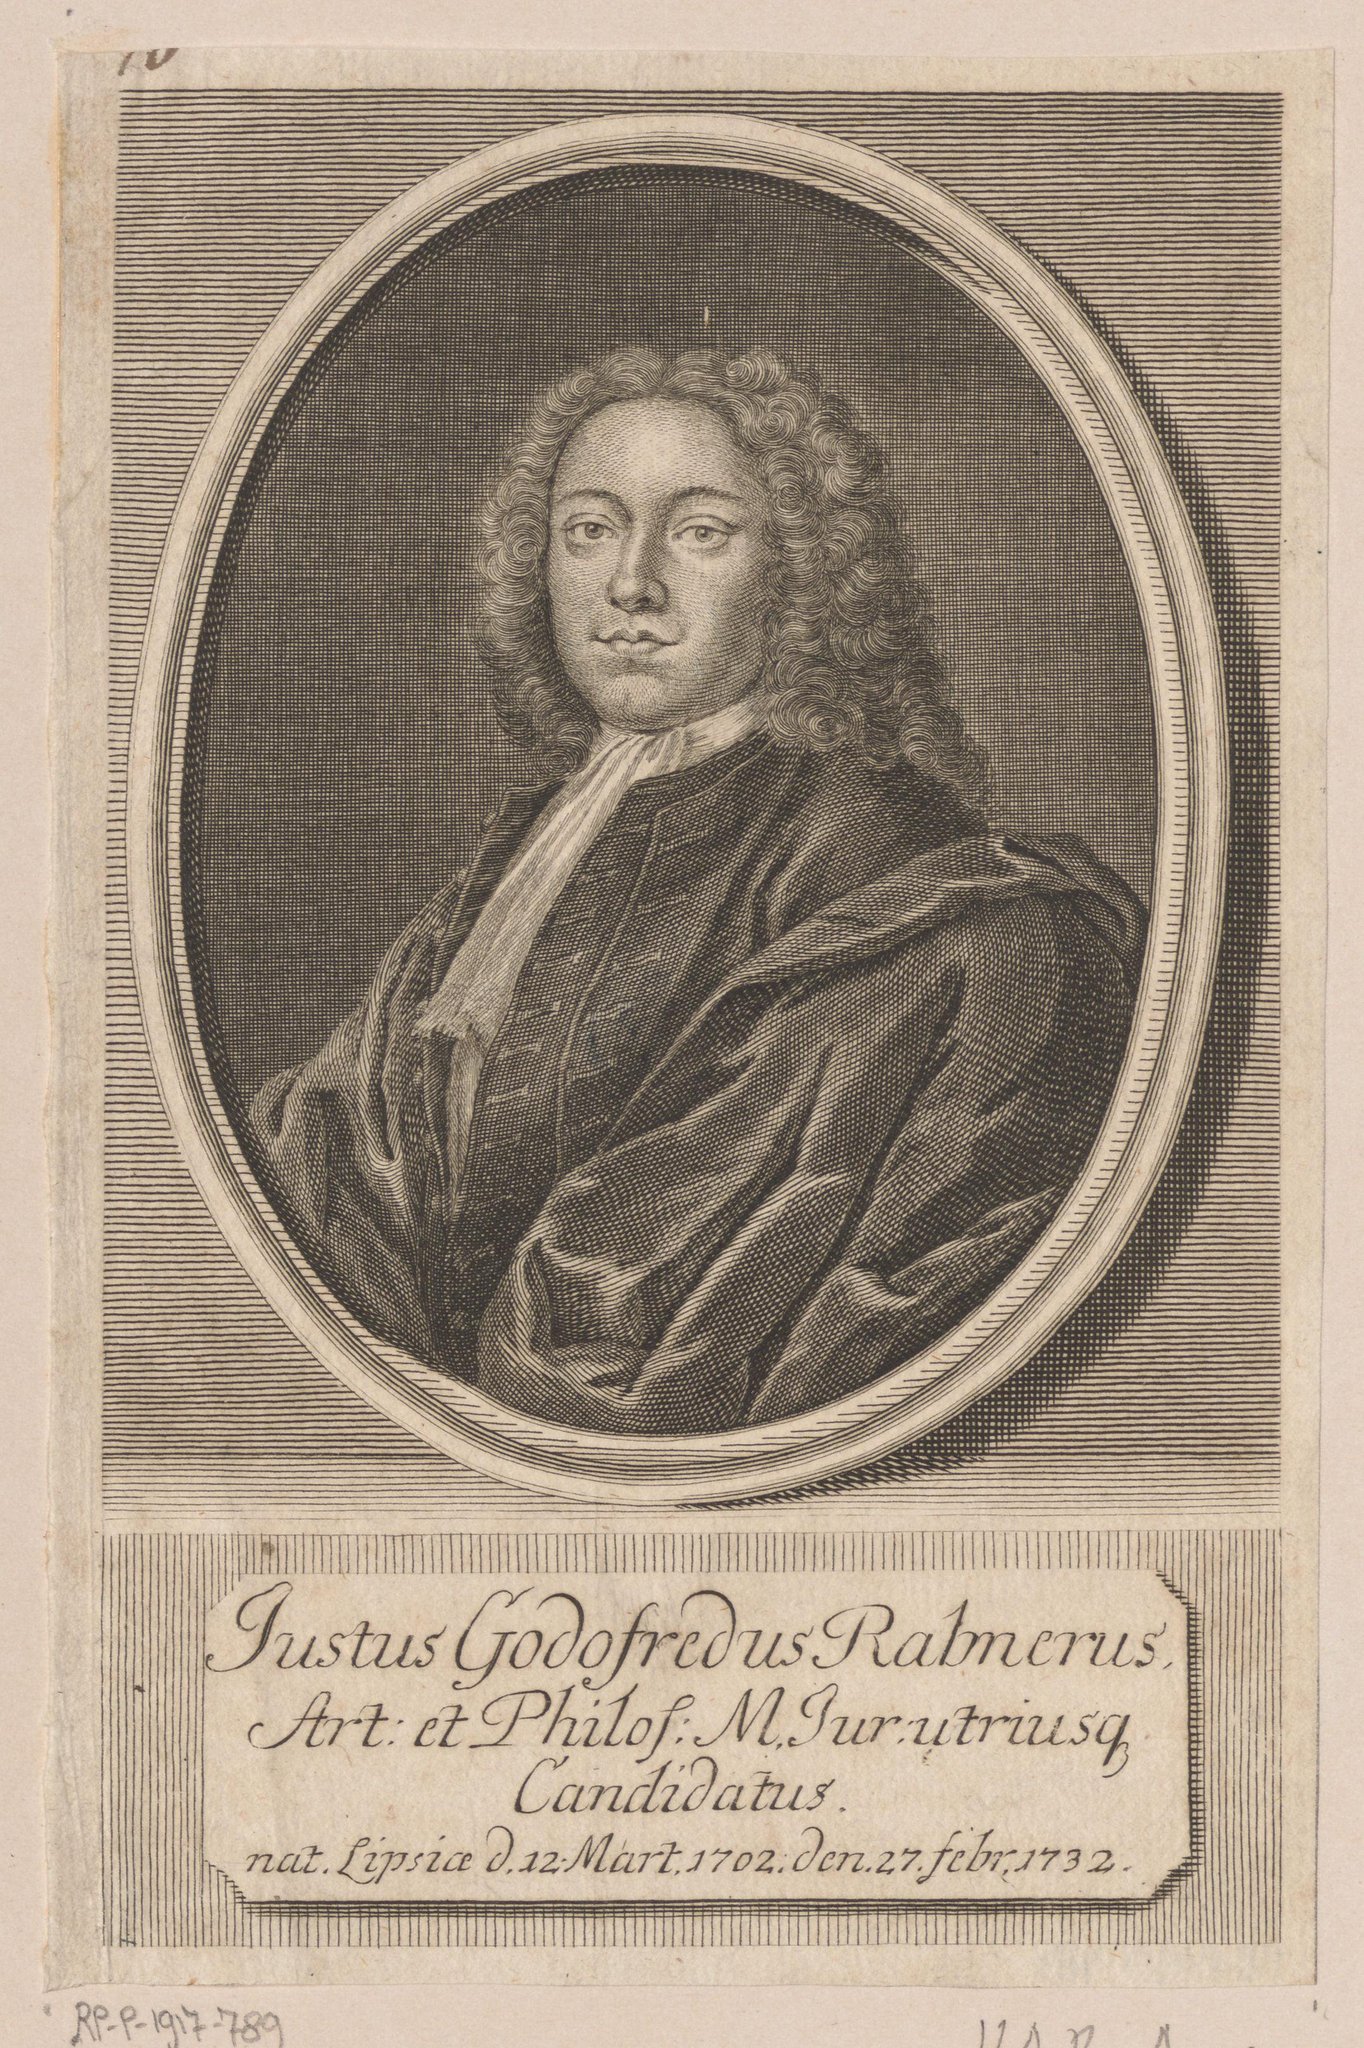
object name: print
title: Portret van de filosoof Justus Gottfried Rabener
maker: johann martin bernigeroth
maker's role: print maker, publisher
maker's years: 1713-1767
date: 1732-1767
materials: paper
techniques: engraving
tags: historical persons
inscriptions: collector's mark: Lugt 2228